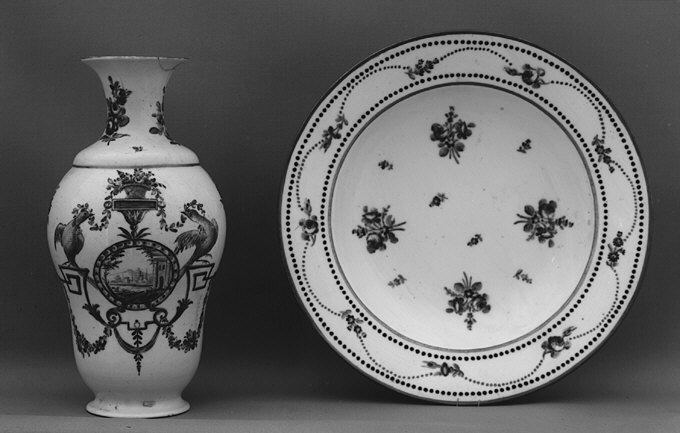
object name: vase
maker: cozzi manufactory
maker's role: factory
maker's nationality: italian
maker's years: 1764-1812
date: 1770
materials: hard paste porcelain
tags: birds,coat of arms